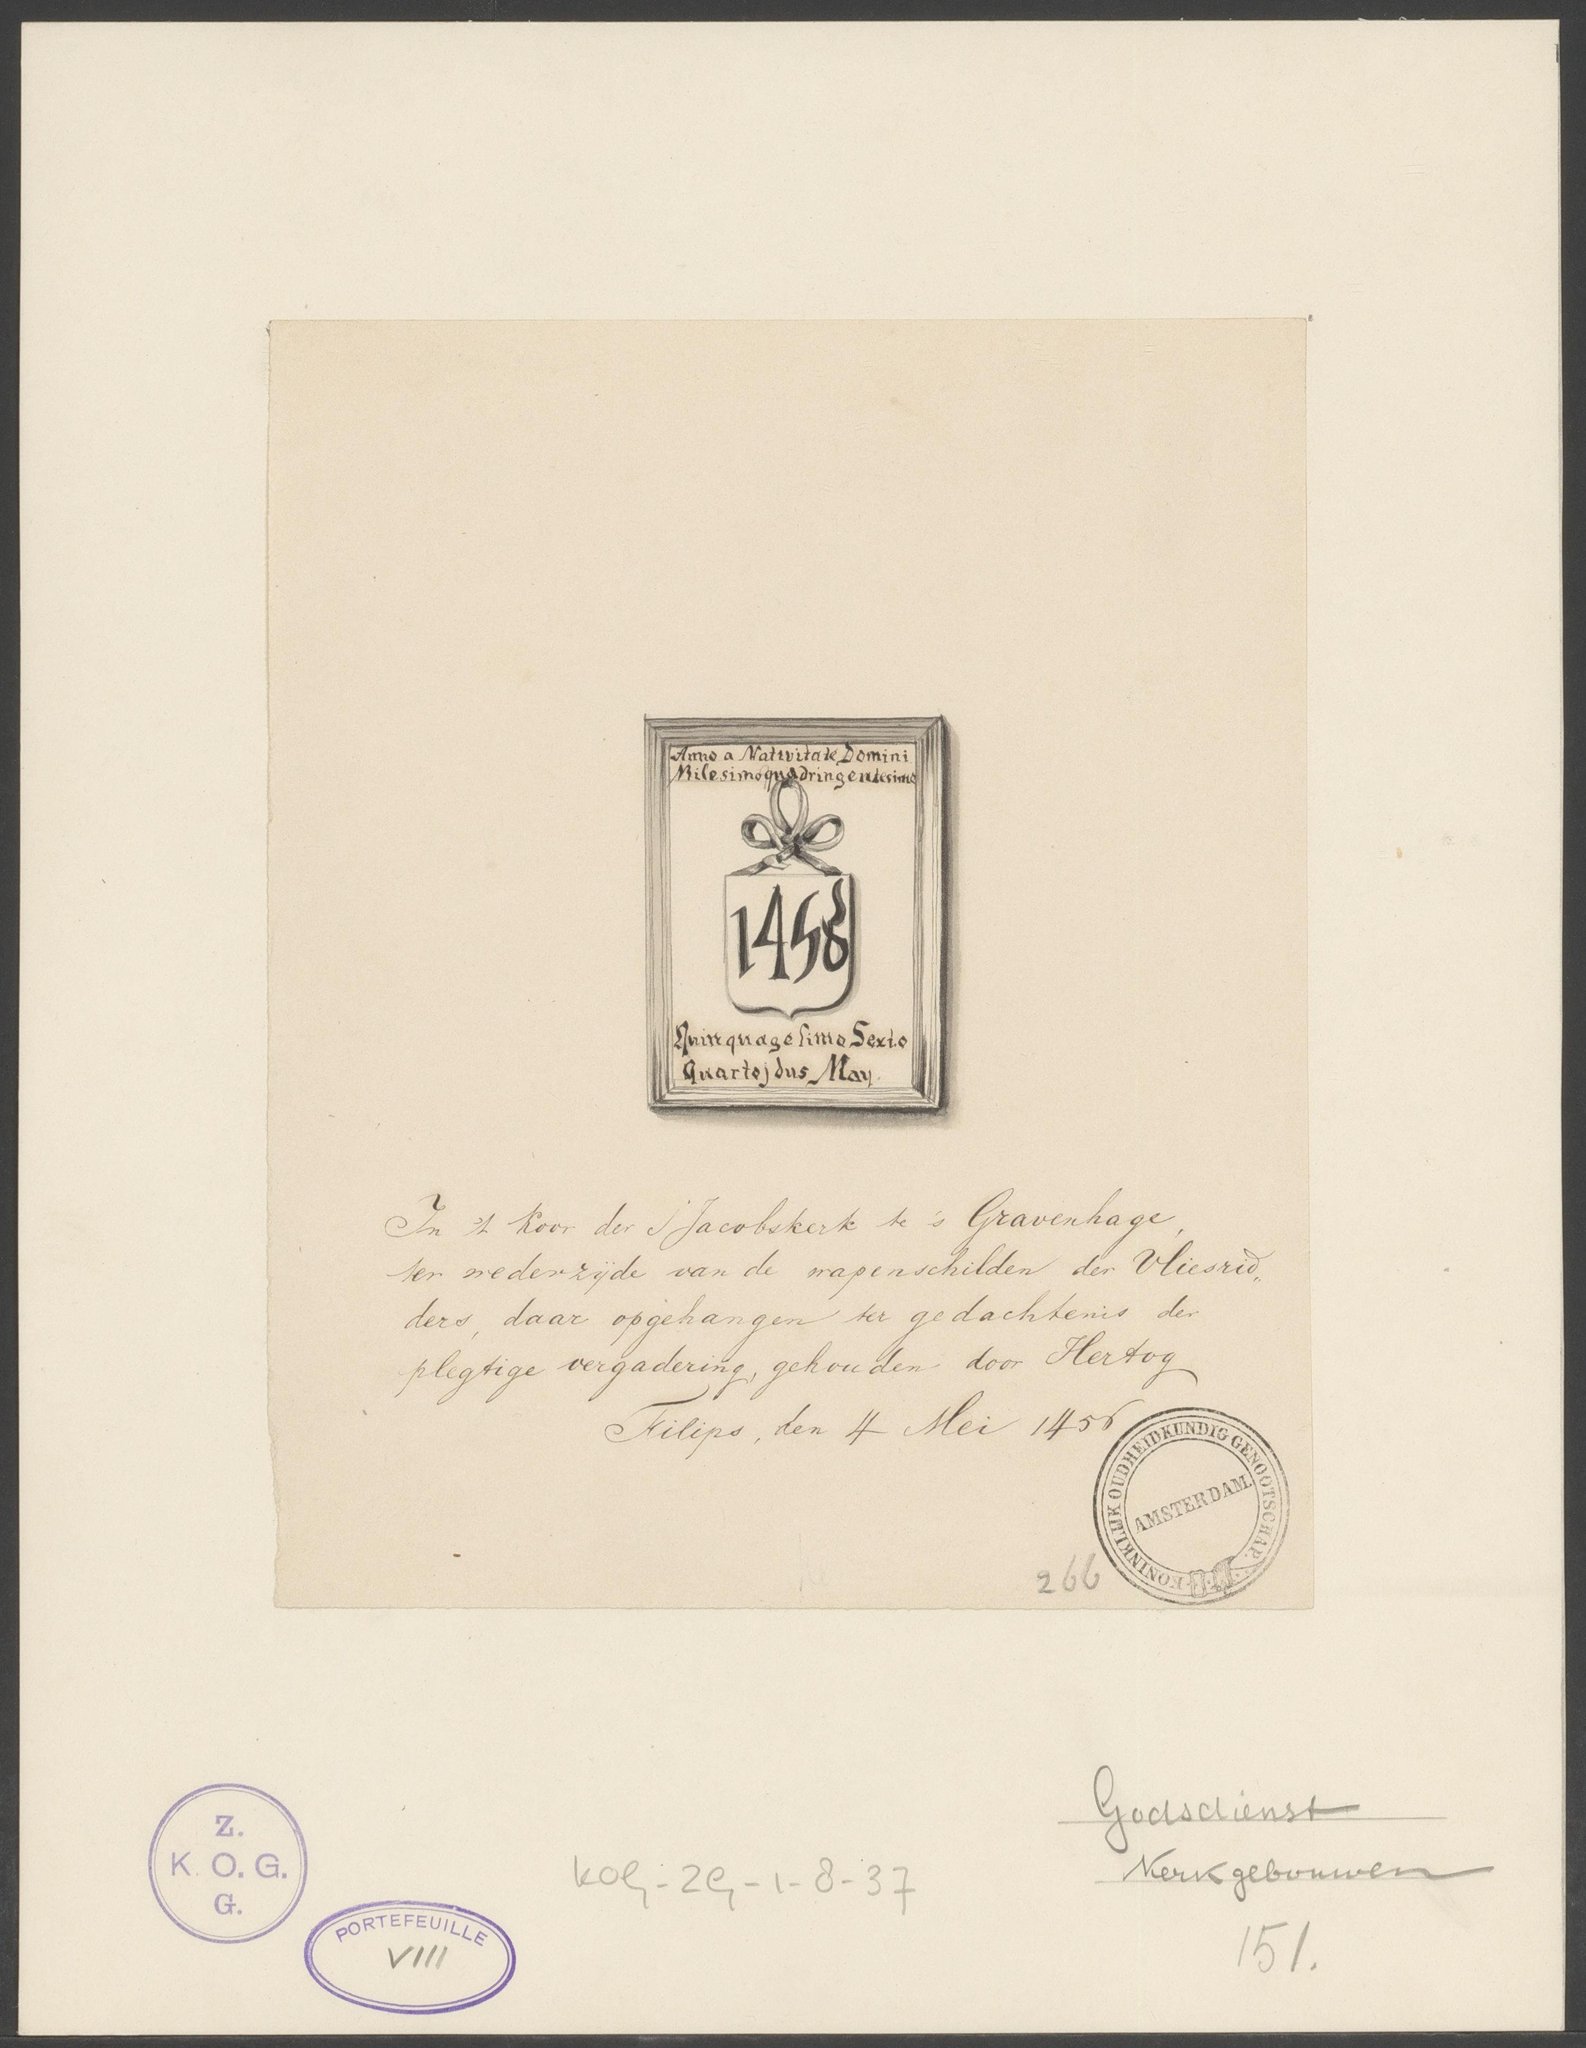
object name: drawing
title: Schild met jaartal 1456 in het koor van de Sint-Jacobskerk te Den Haag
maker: Anonymous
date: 1850-1950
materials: ink, paper, pencil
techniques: brush, pen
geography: netherlands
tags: other festivities connected to calendar dates; memorial days, interior of church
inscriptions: collector's mark, collector's mark:, collector's mark: Lugt 1641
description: Aftekening van het schild met opschrift en het jaartal 1456 opgehangen in het koor van de Grote of Sint-Jacobskerk te Den Haag. Ter gedachtenis aan de plechtige vergadering daar gehouden door hertog Filips op 4 mei 1456. Blad met tekening, opschrift en stempel. Onderwerpsrubrieken binnen de Atlas Zeden en Gewoonten: Kerk en kerkwezen & Armwezen en liefdadige instellingen; Kerkgebouwen elders. F-L.